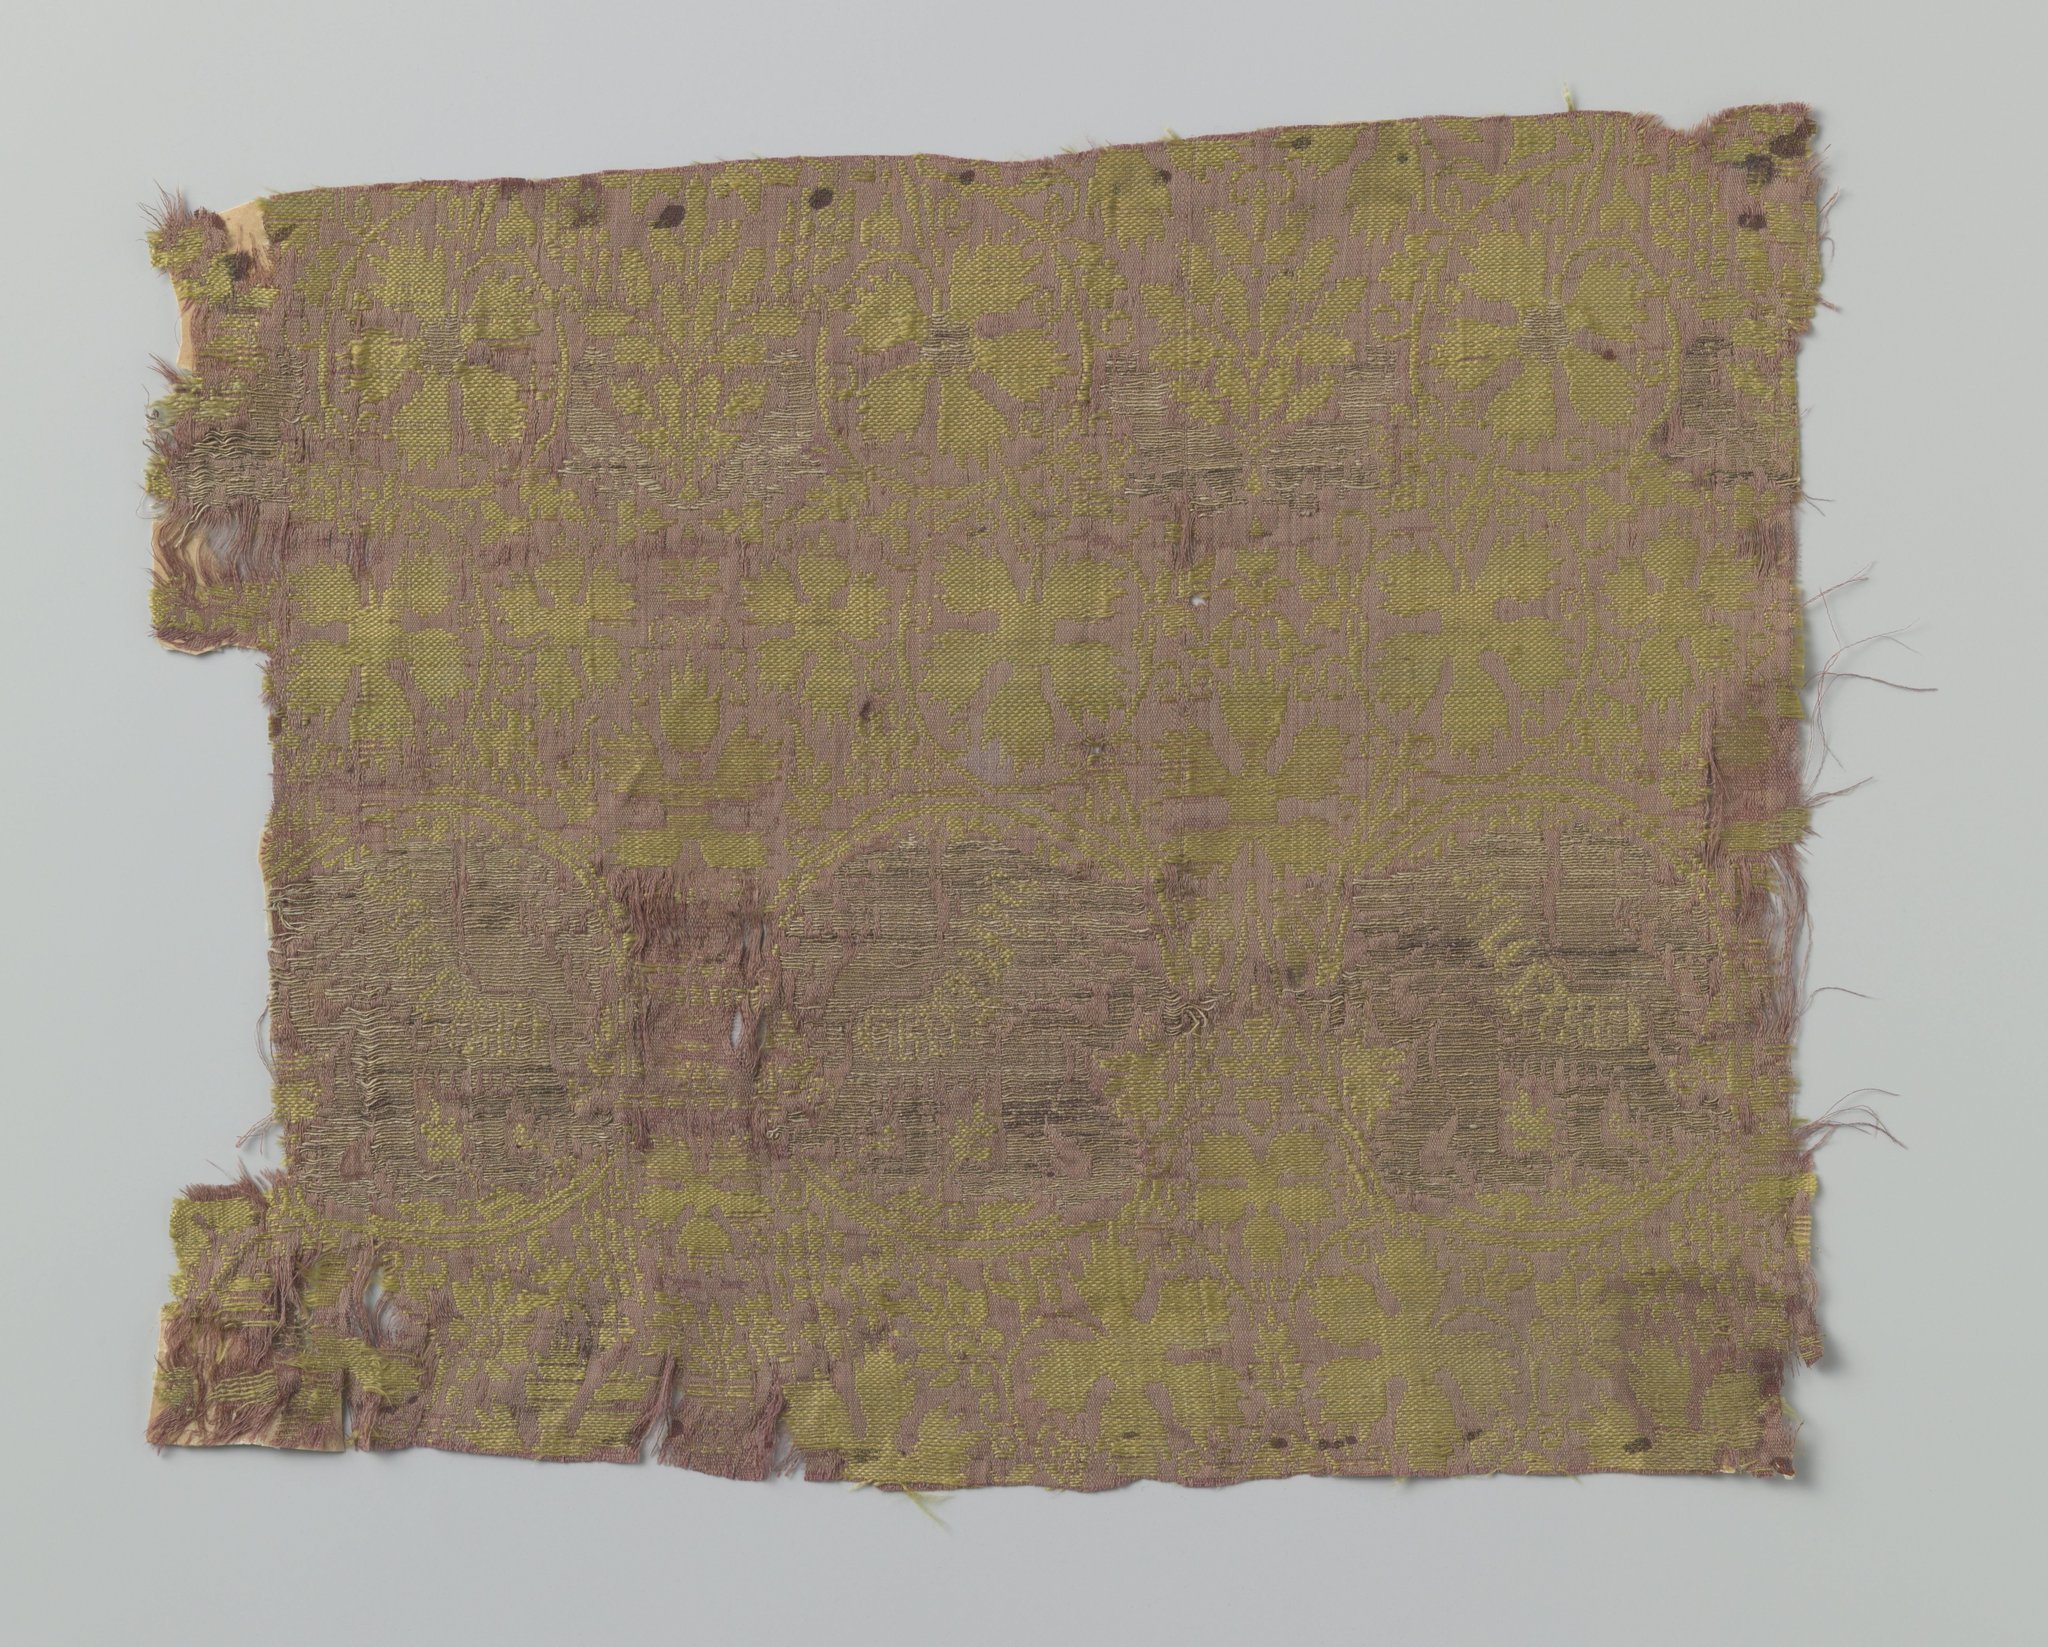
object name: silk textile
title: Fragment zijdeweefsel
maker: Anonymous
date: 1300-1399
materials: metal thread, silk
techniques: brocade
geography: italy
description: Fragment rood-paarse zijde met patroon in geel van cirkels en banden omgeven door wijnranken. In de cirkels met gouddraad telkens een tegenovergestelde lopende griffioen met op de vleugel "Grifone". In de banden zittende vogels.